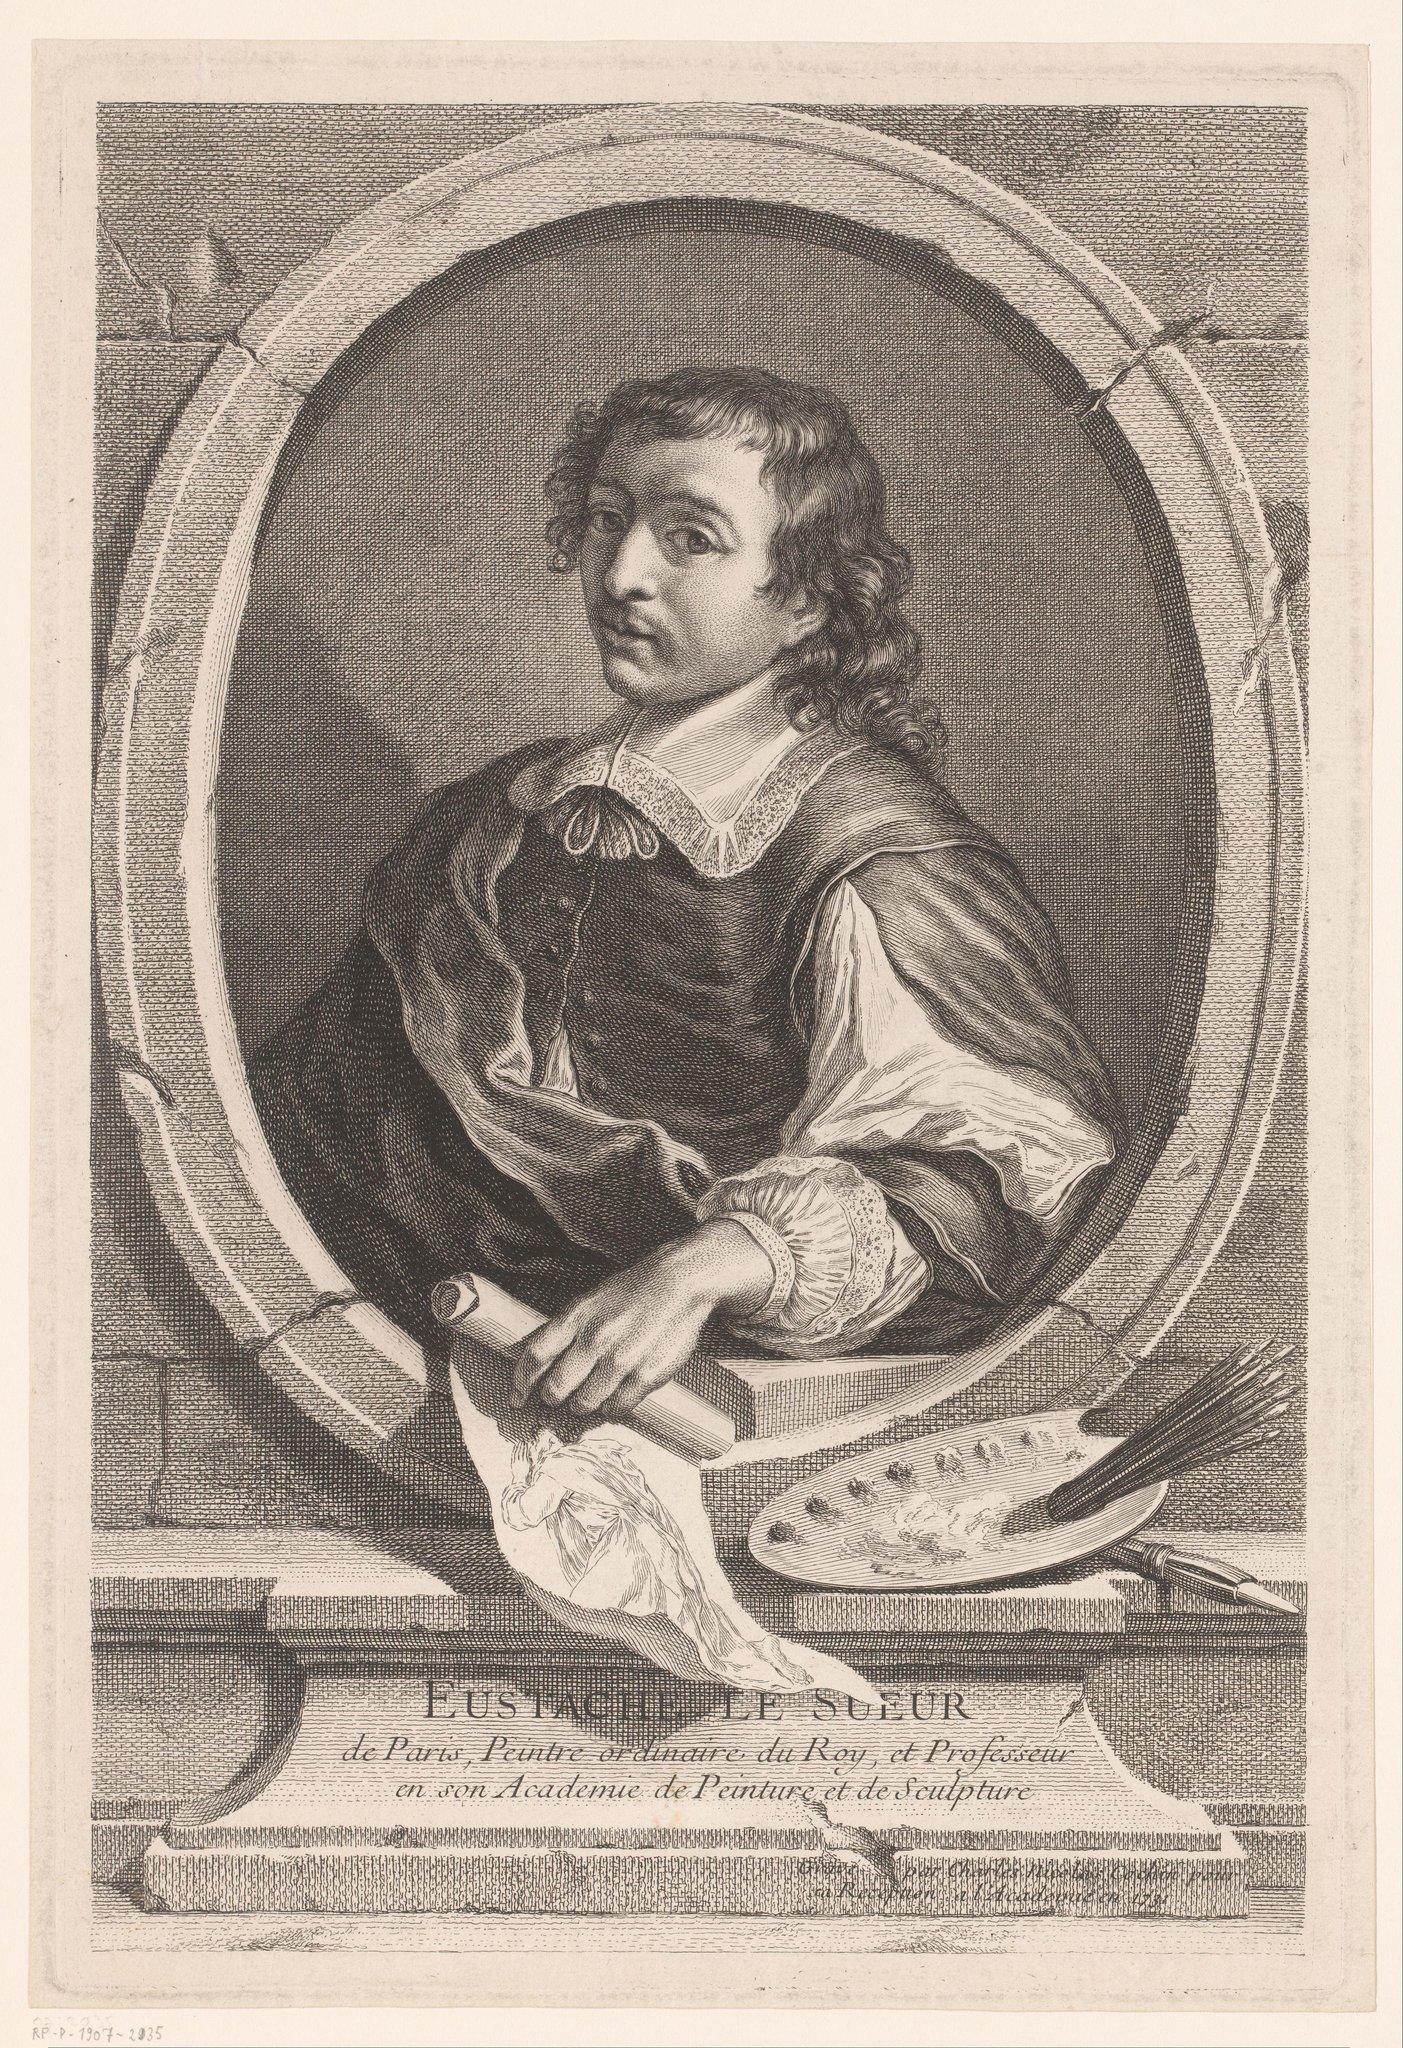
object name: print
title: Eustache le Sueur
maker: charles nicolas cochin (i)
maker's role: print maker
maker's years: 1688-1754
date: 1731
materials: paper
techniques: engraving, etching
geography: france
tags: paris, painter, draughtsman, eustache lesueur, ornament ~ medallion, portrait, self-portrait of painter, palette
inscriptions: collector's mark: Lugt 2228